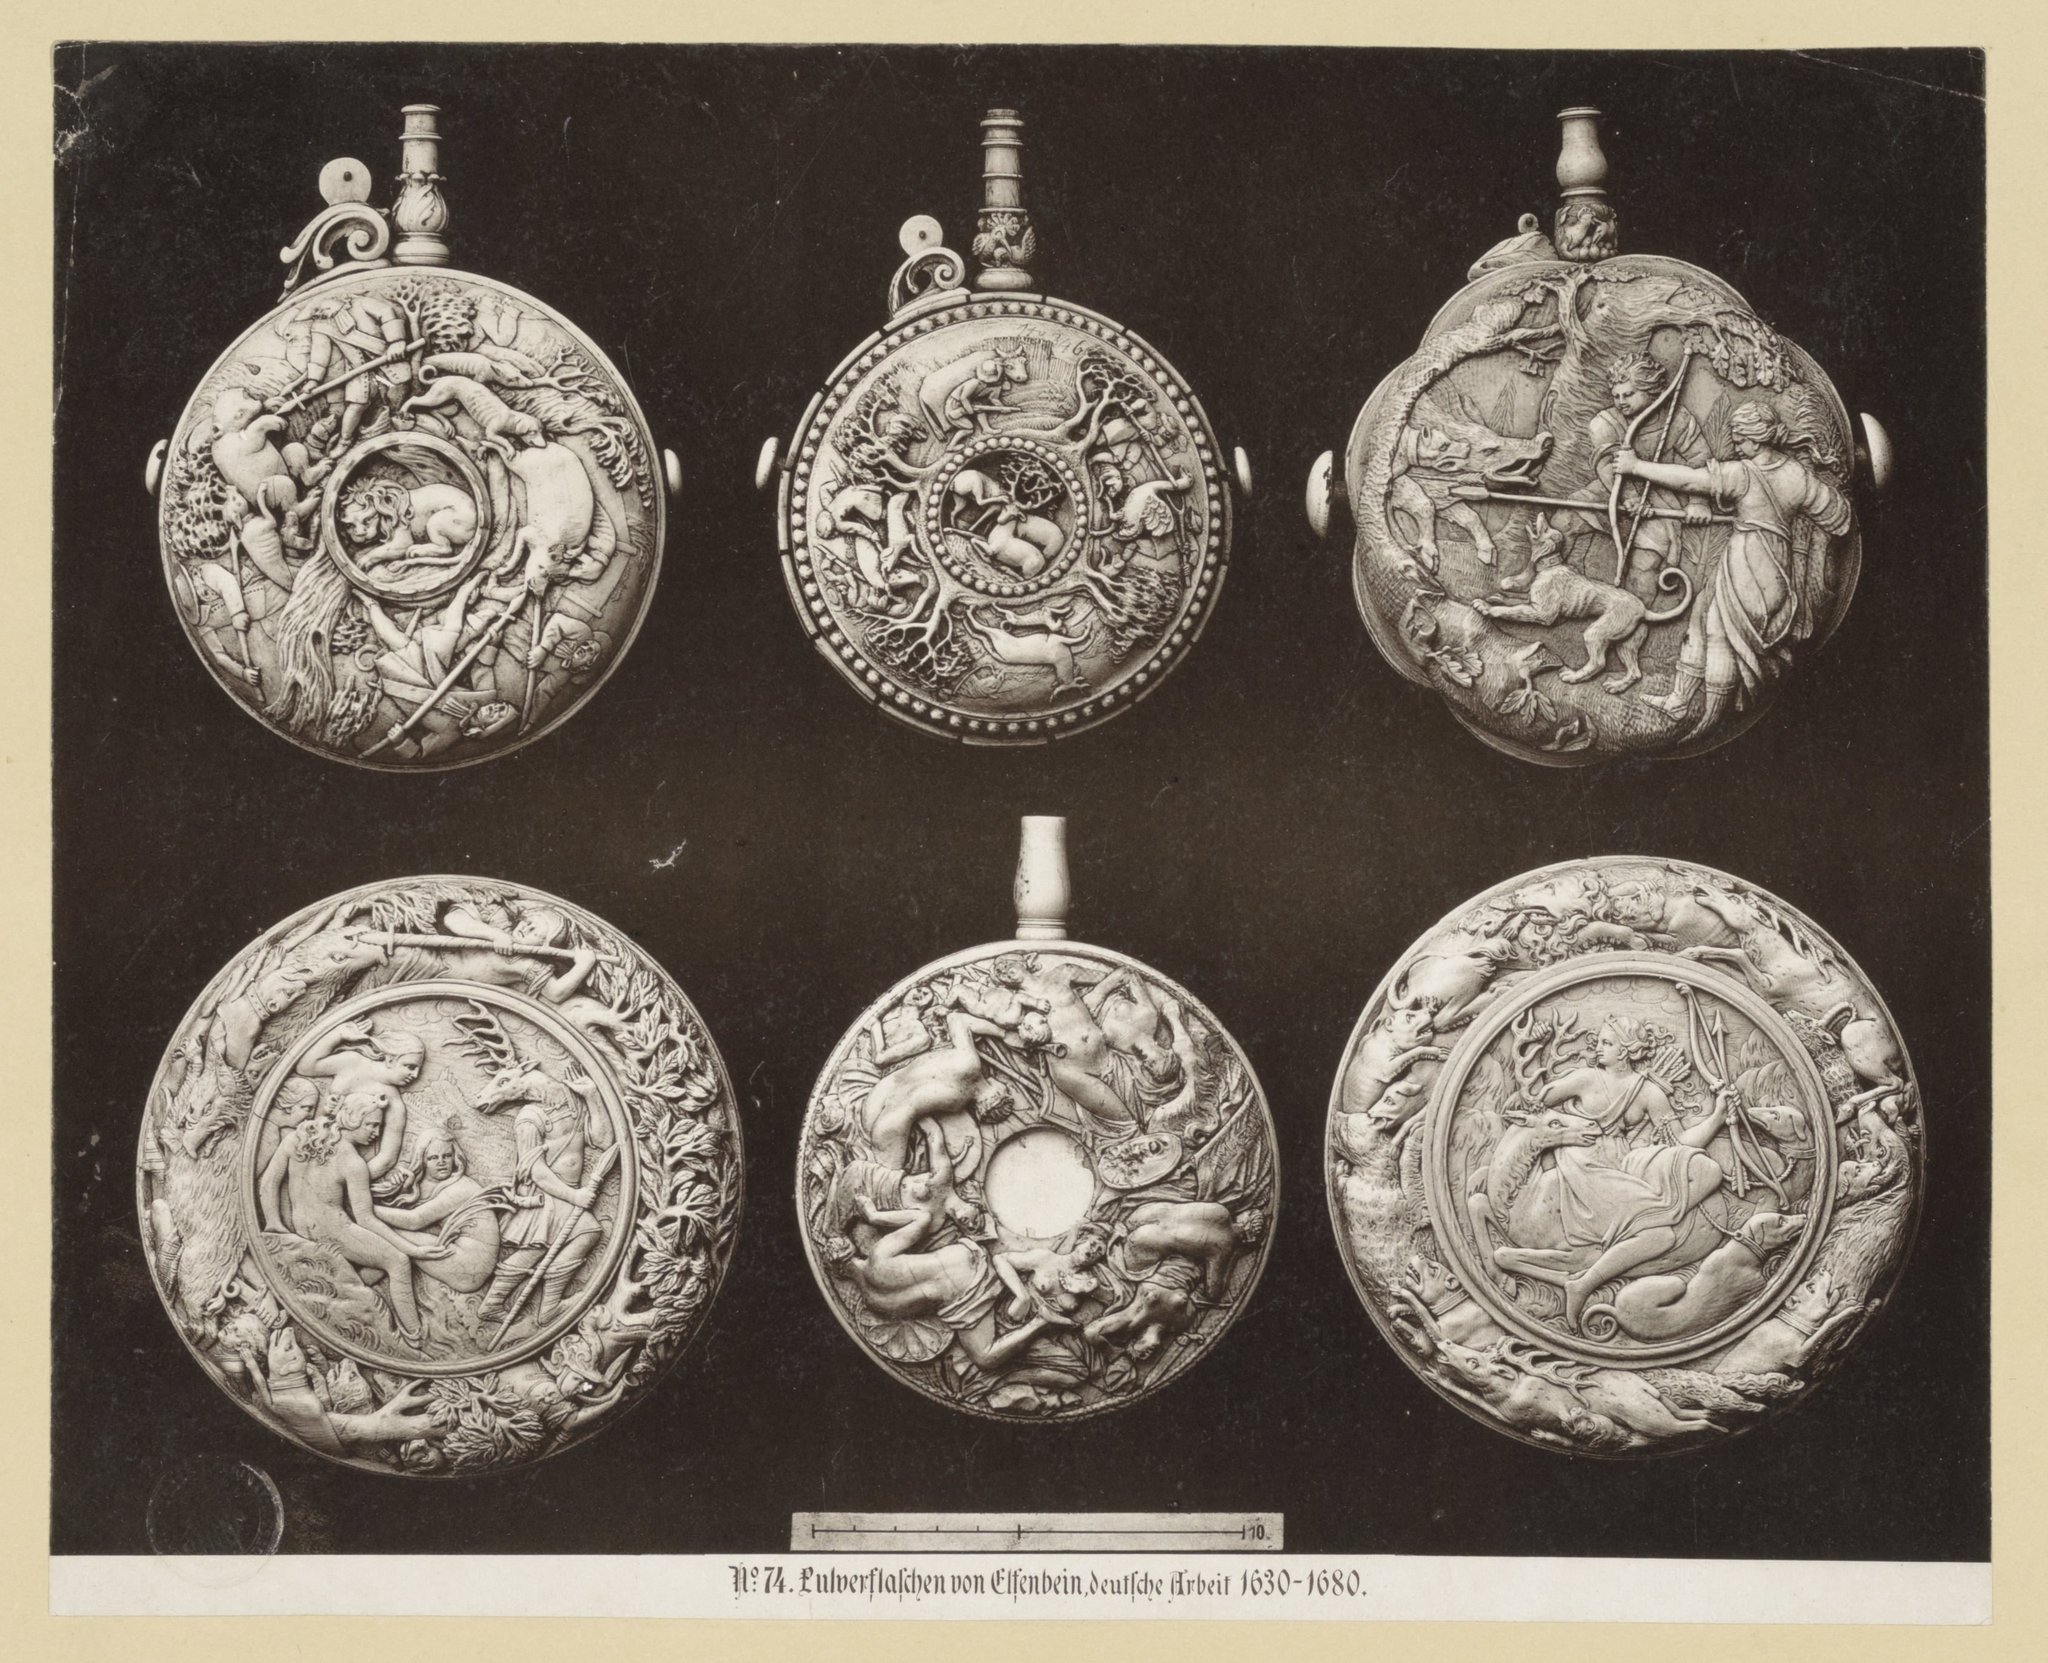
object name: photomechanical print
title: Pulverflaschen von Elfenbein, deutsche Arbeit 1630-1680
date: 1869-1887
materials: cardboard, paper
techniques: photograph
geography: munich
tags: containers, work of applied art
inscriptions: check stamp: ‘Bayerisches National-Museum’, number: ‘No. 74.’